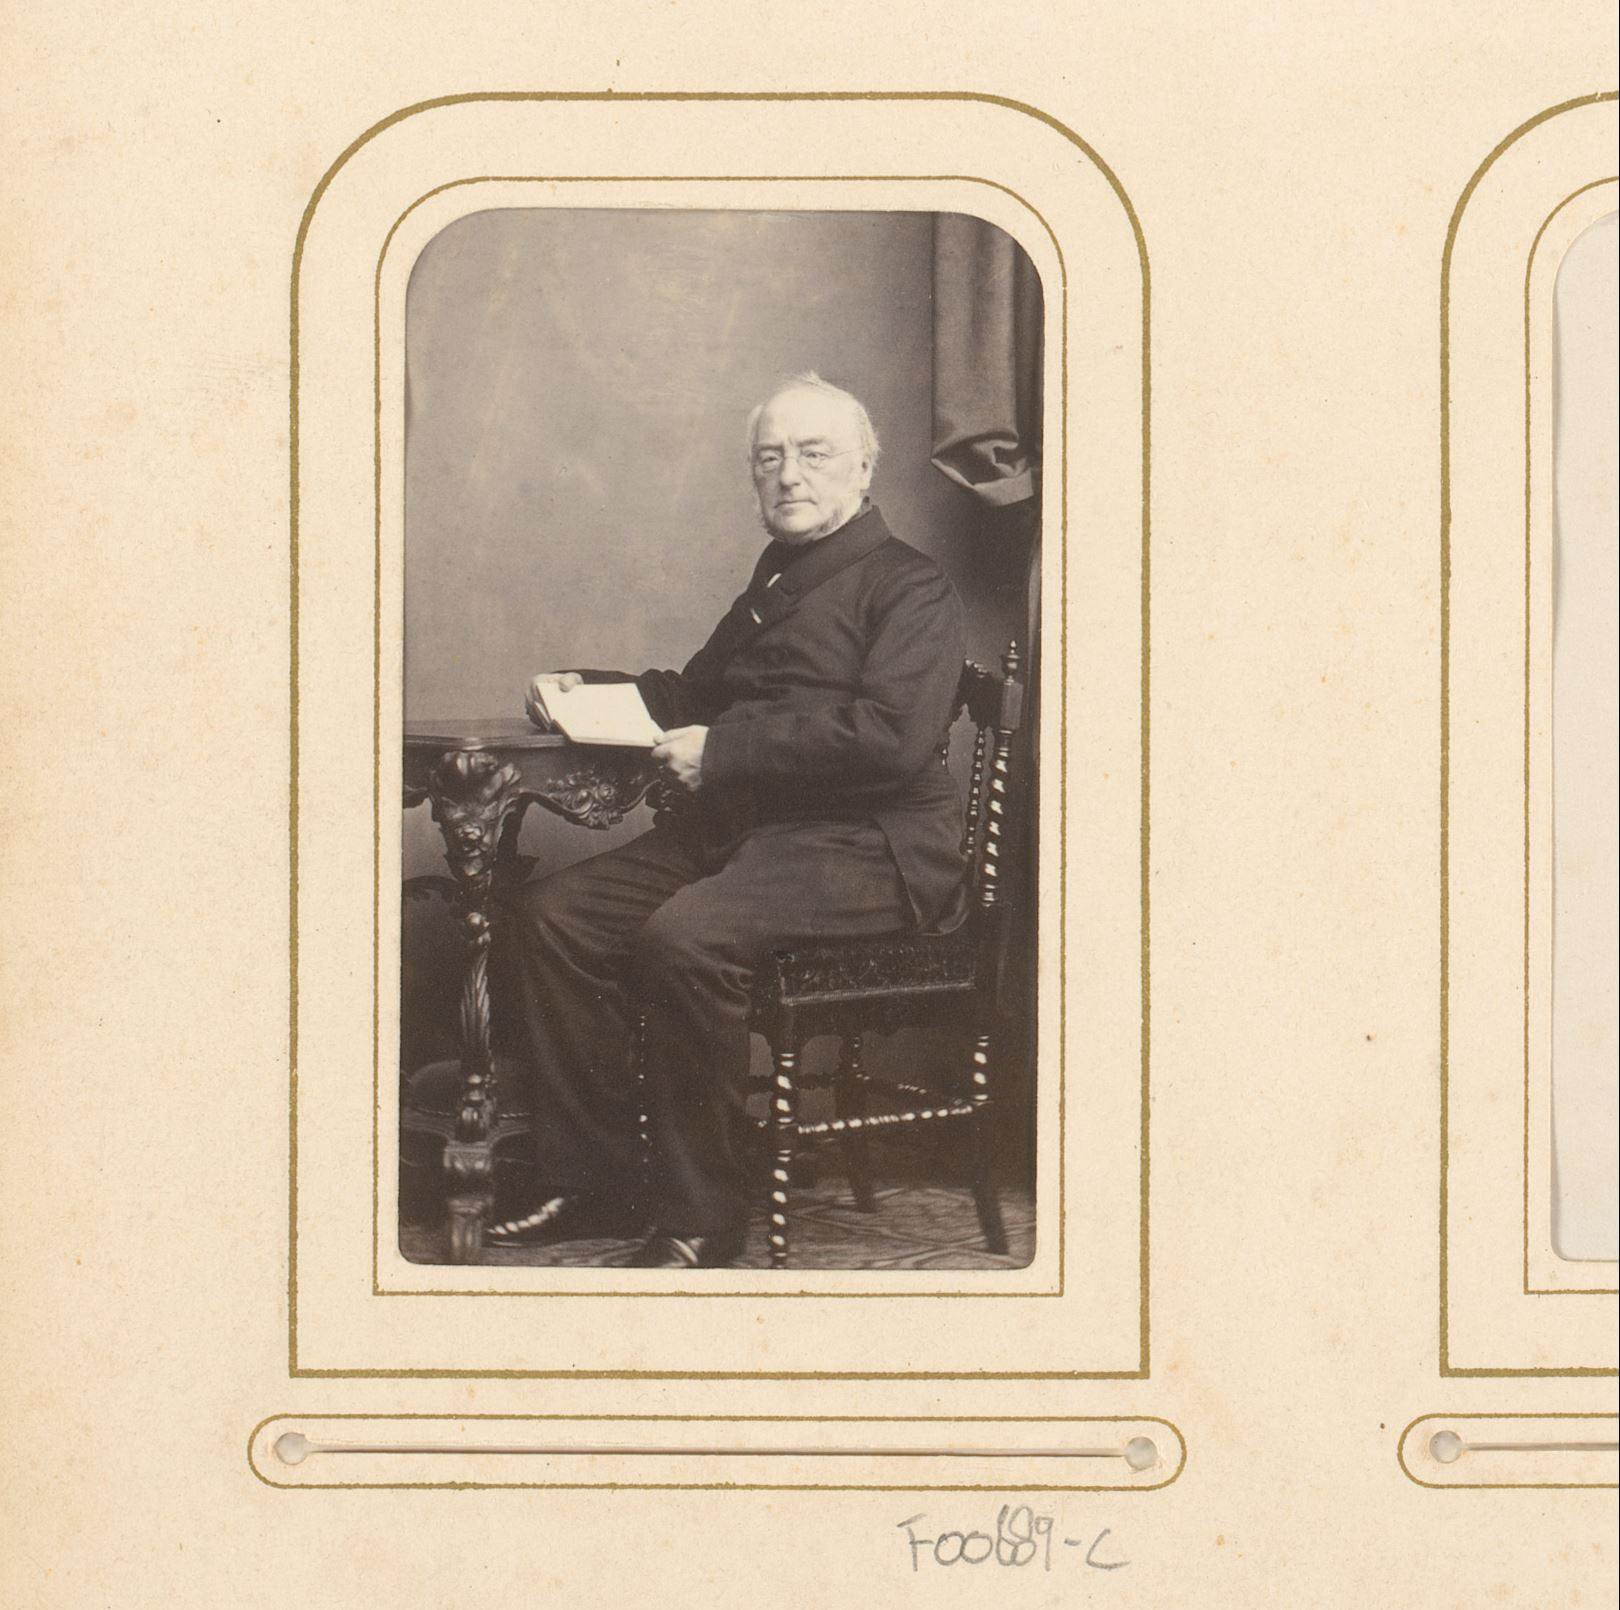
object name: carte de visite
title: Portret van een zittende man met boek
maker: Anonymous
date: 1860-1900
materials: cardboard, photographic support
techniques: albumen print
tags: historical persons